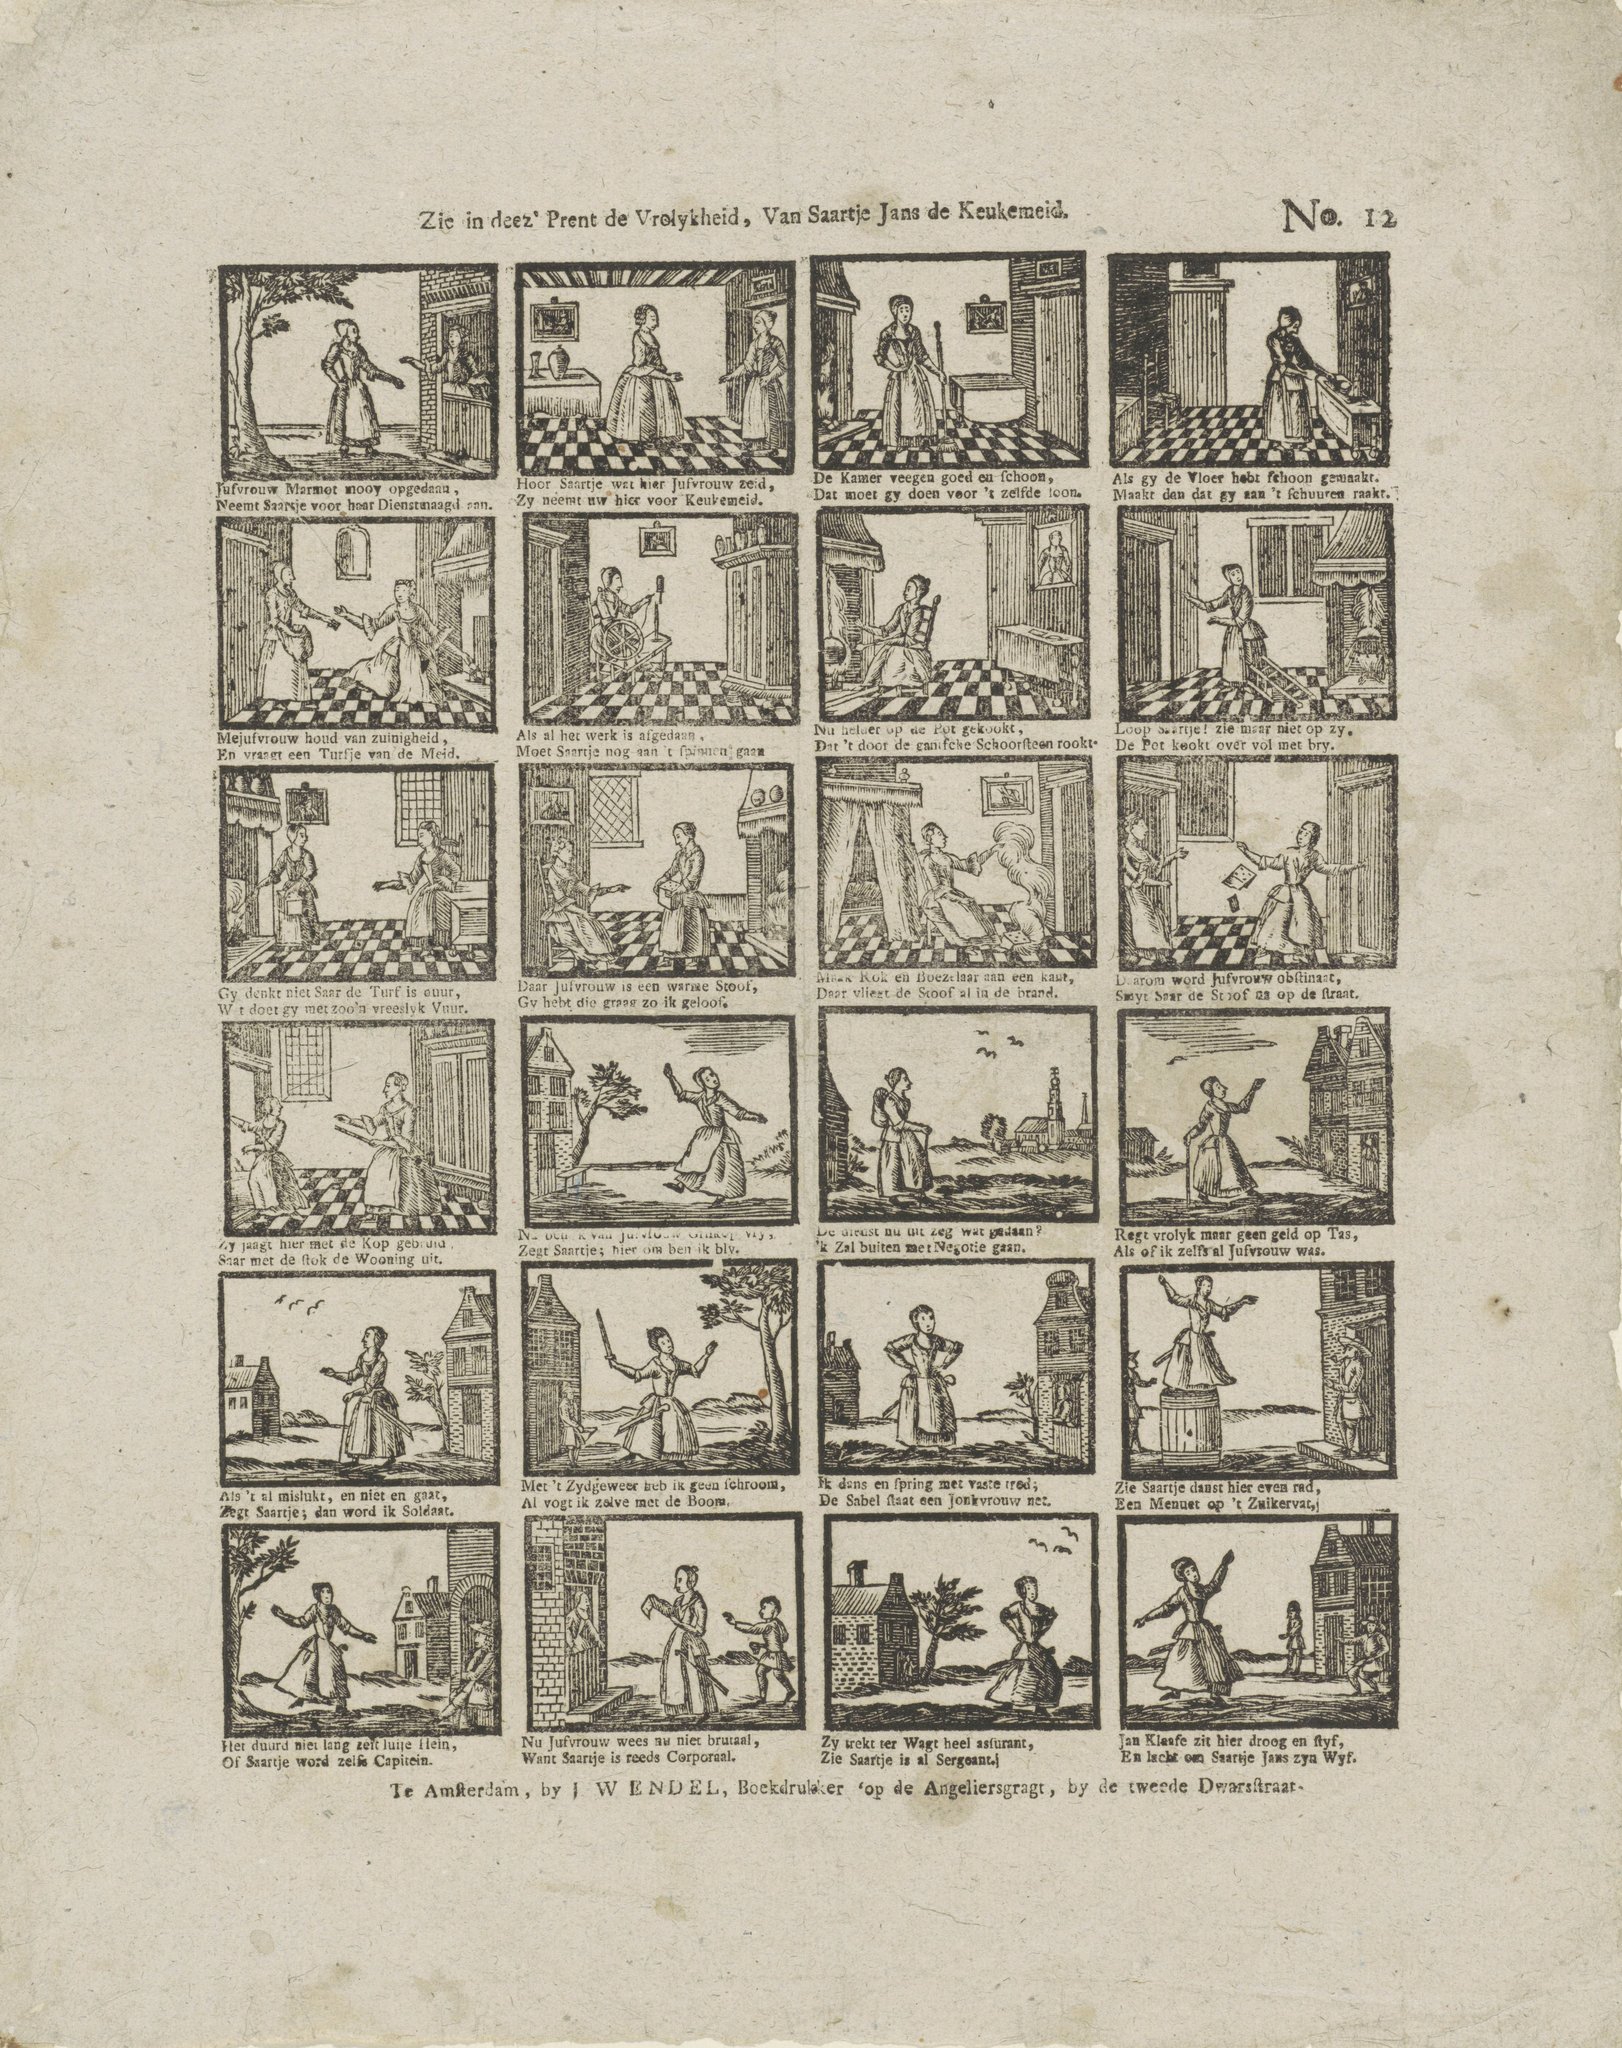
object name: popular print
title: Zie in deez' prent de vrolykheid, / Van Saartje Jans de keukemeid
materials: paper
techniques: letterpress printing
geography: netherlands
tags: the soldier; the soldier's life, kitchen-maid, kitchen servant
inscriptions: collector's mark: Lugt 2760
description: Blad met 24 voorstellingen uit het leven van Saartje Jans de keukenmeid. In de eerste scènes werkt zij als keukenmeid, maar wordt ontslagen omdat zij teveel van de dure turf gebruikt voor het koken. Daarna wordt zij soldaat. Onder elke afbeelding een tweeregelig vers. Genummerd rechtsboven: No. 12.